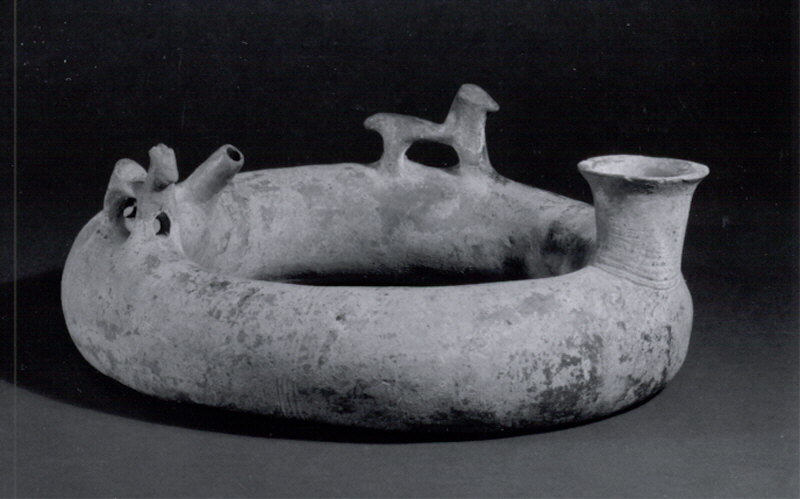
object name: flask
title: Ring flask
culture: iranian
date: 1000-1 BCE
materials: ceramic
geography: northwestern iran, caspian region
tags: animals